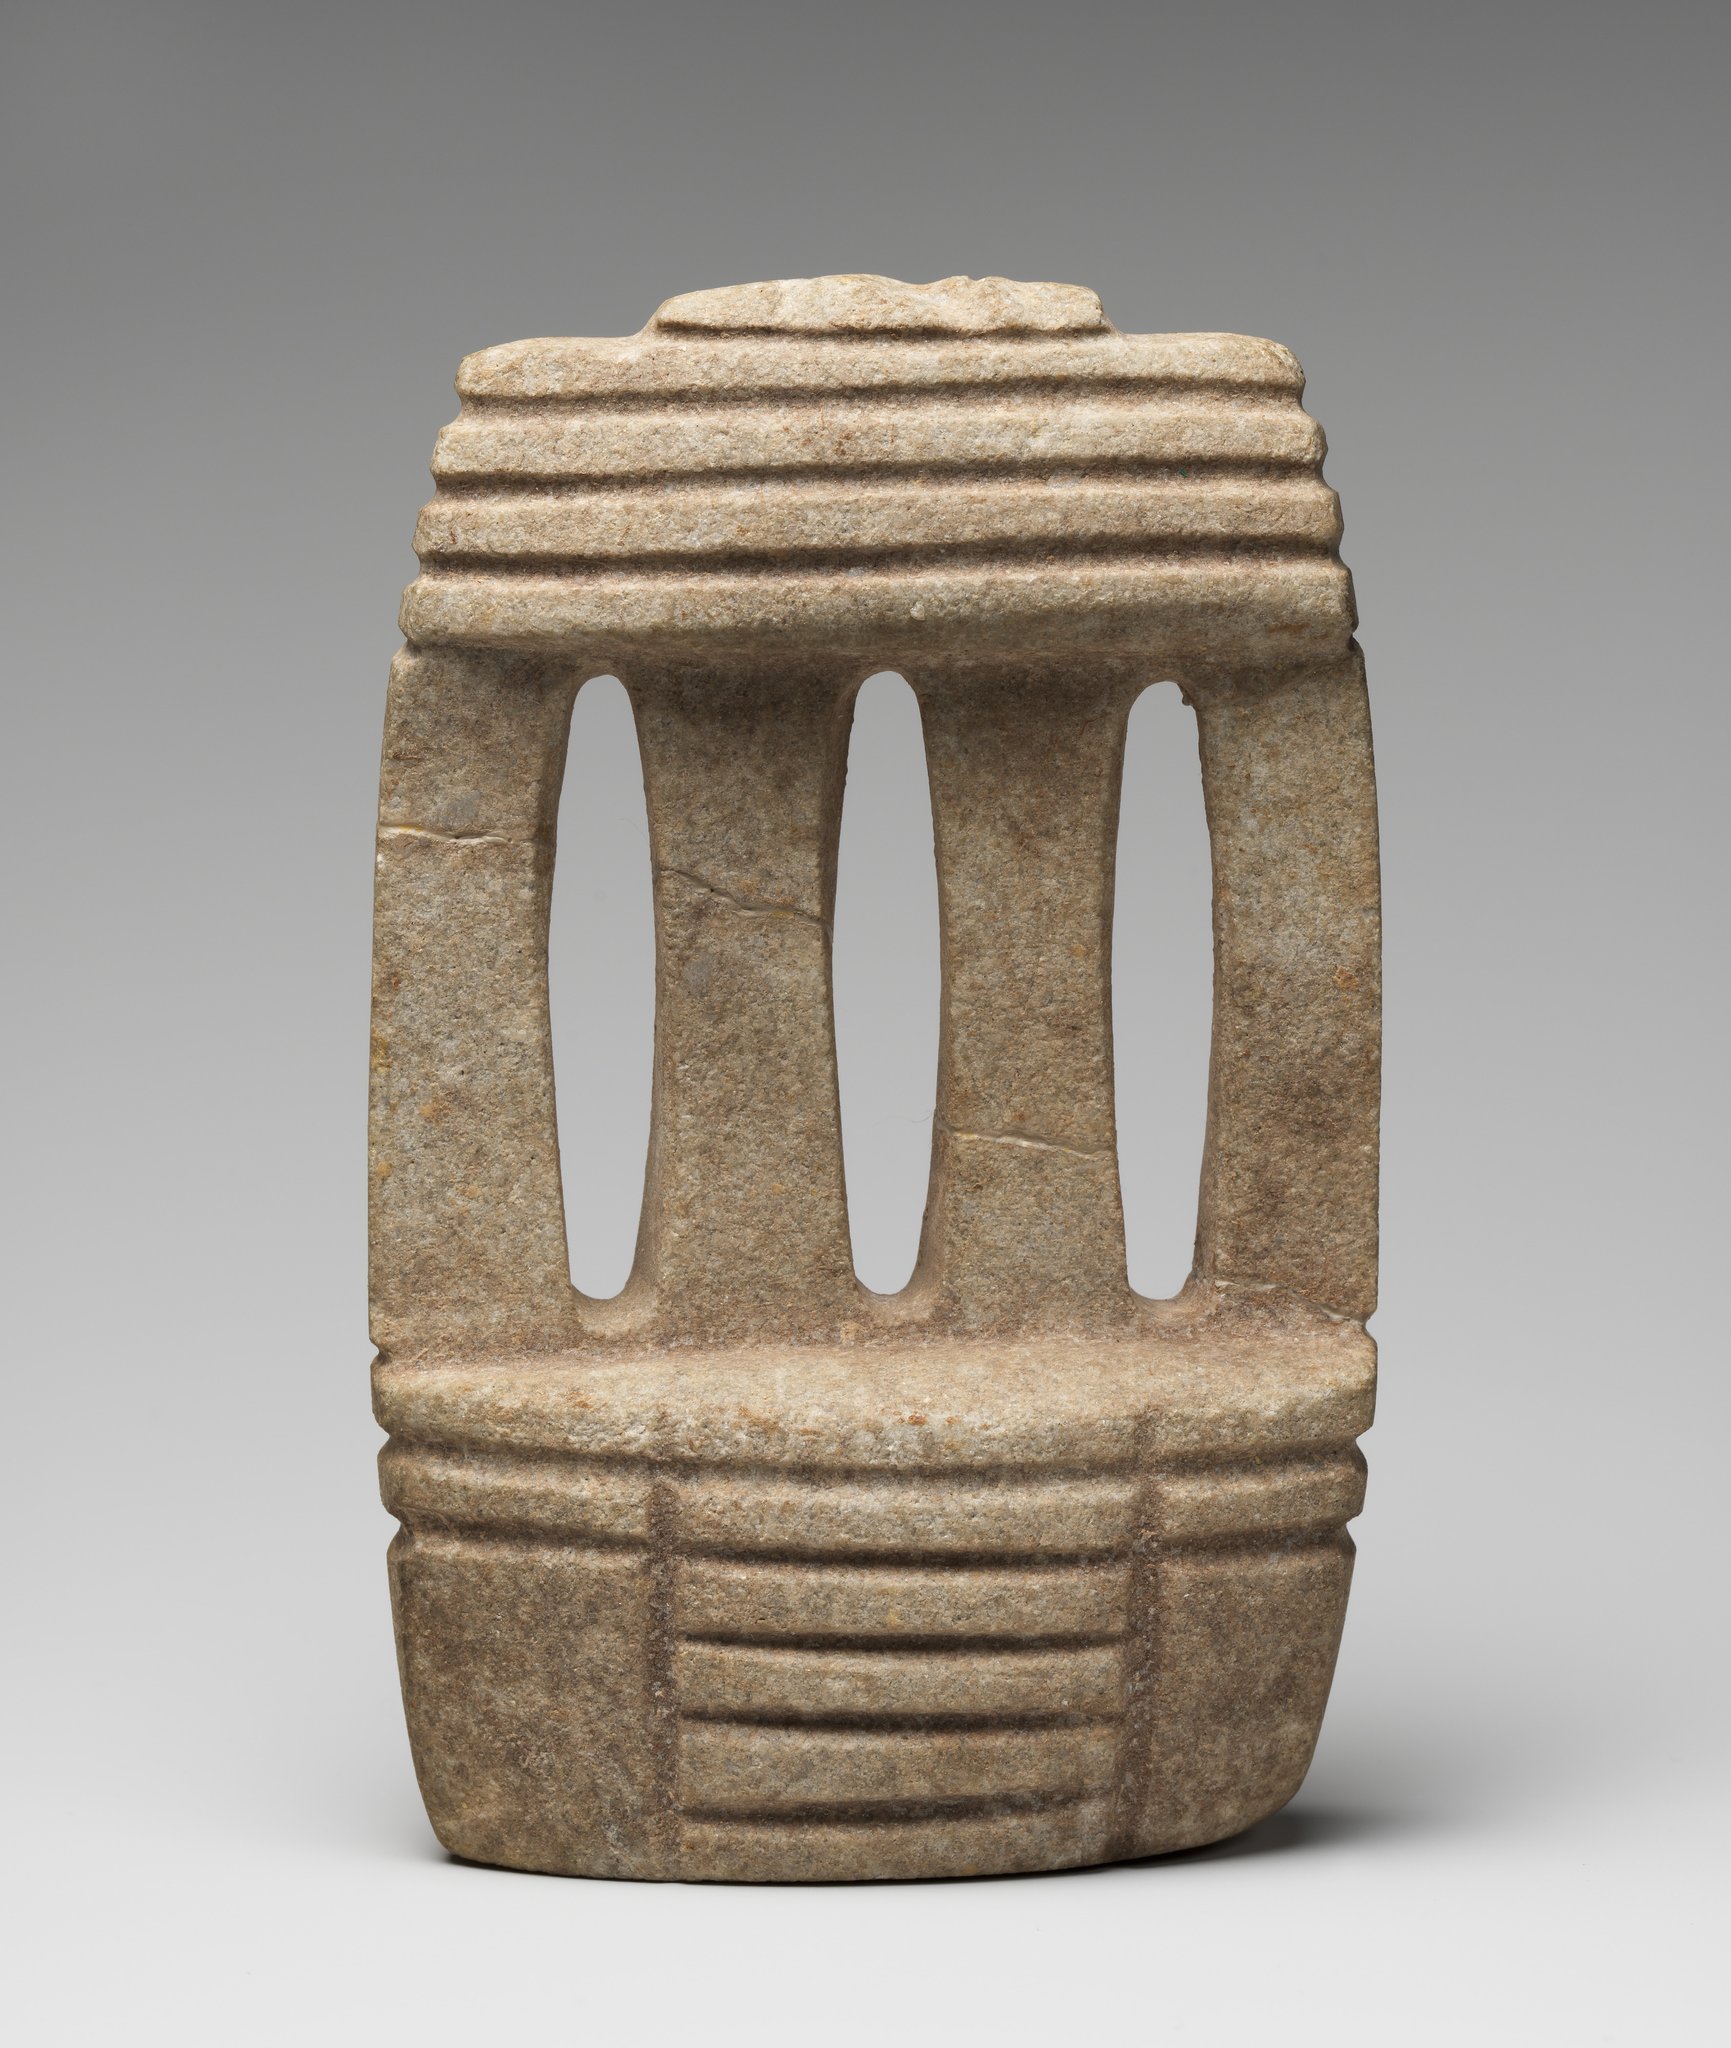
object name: architectural model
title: Architectural model with figure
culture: mezcala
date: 1-800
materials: stone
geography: mexico